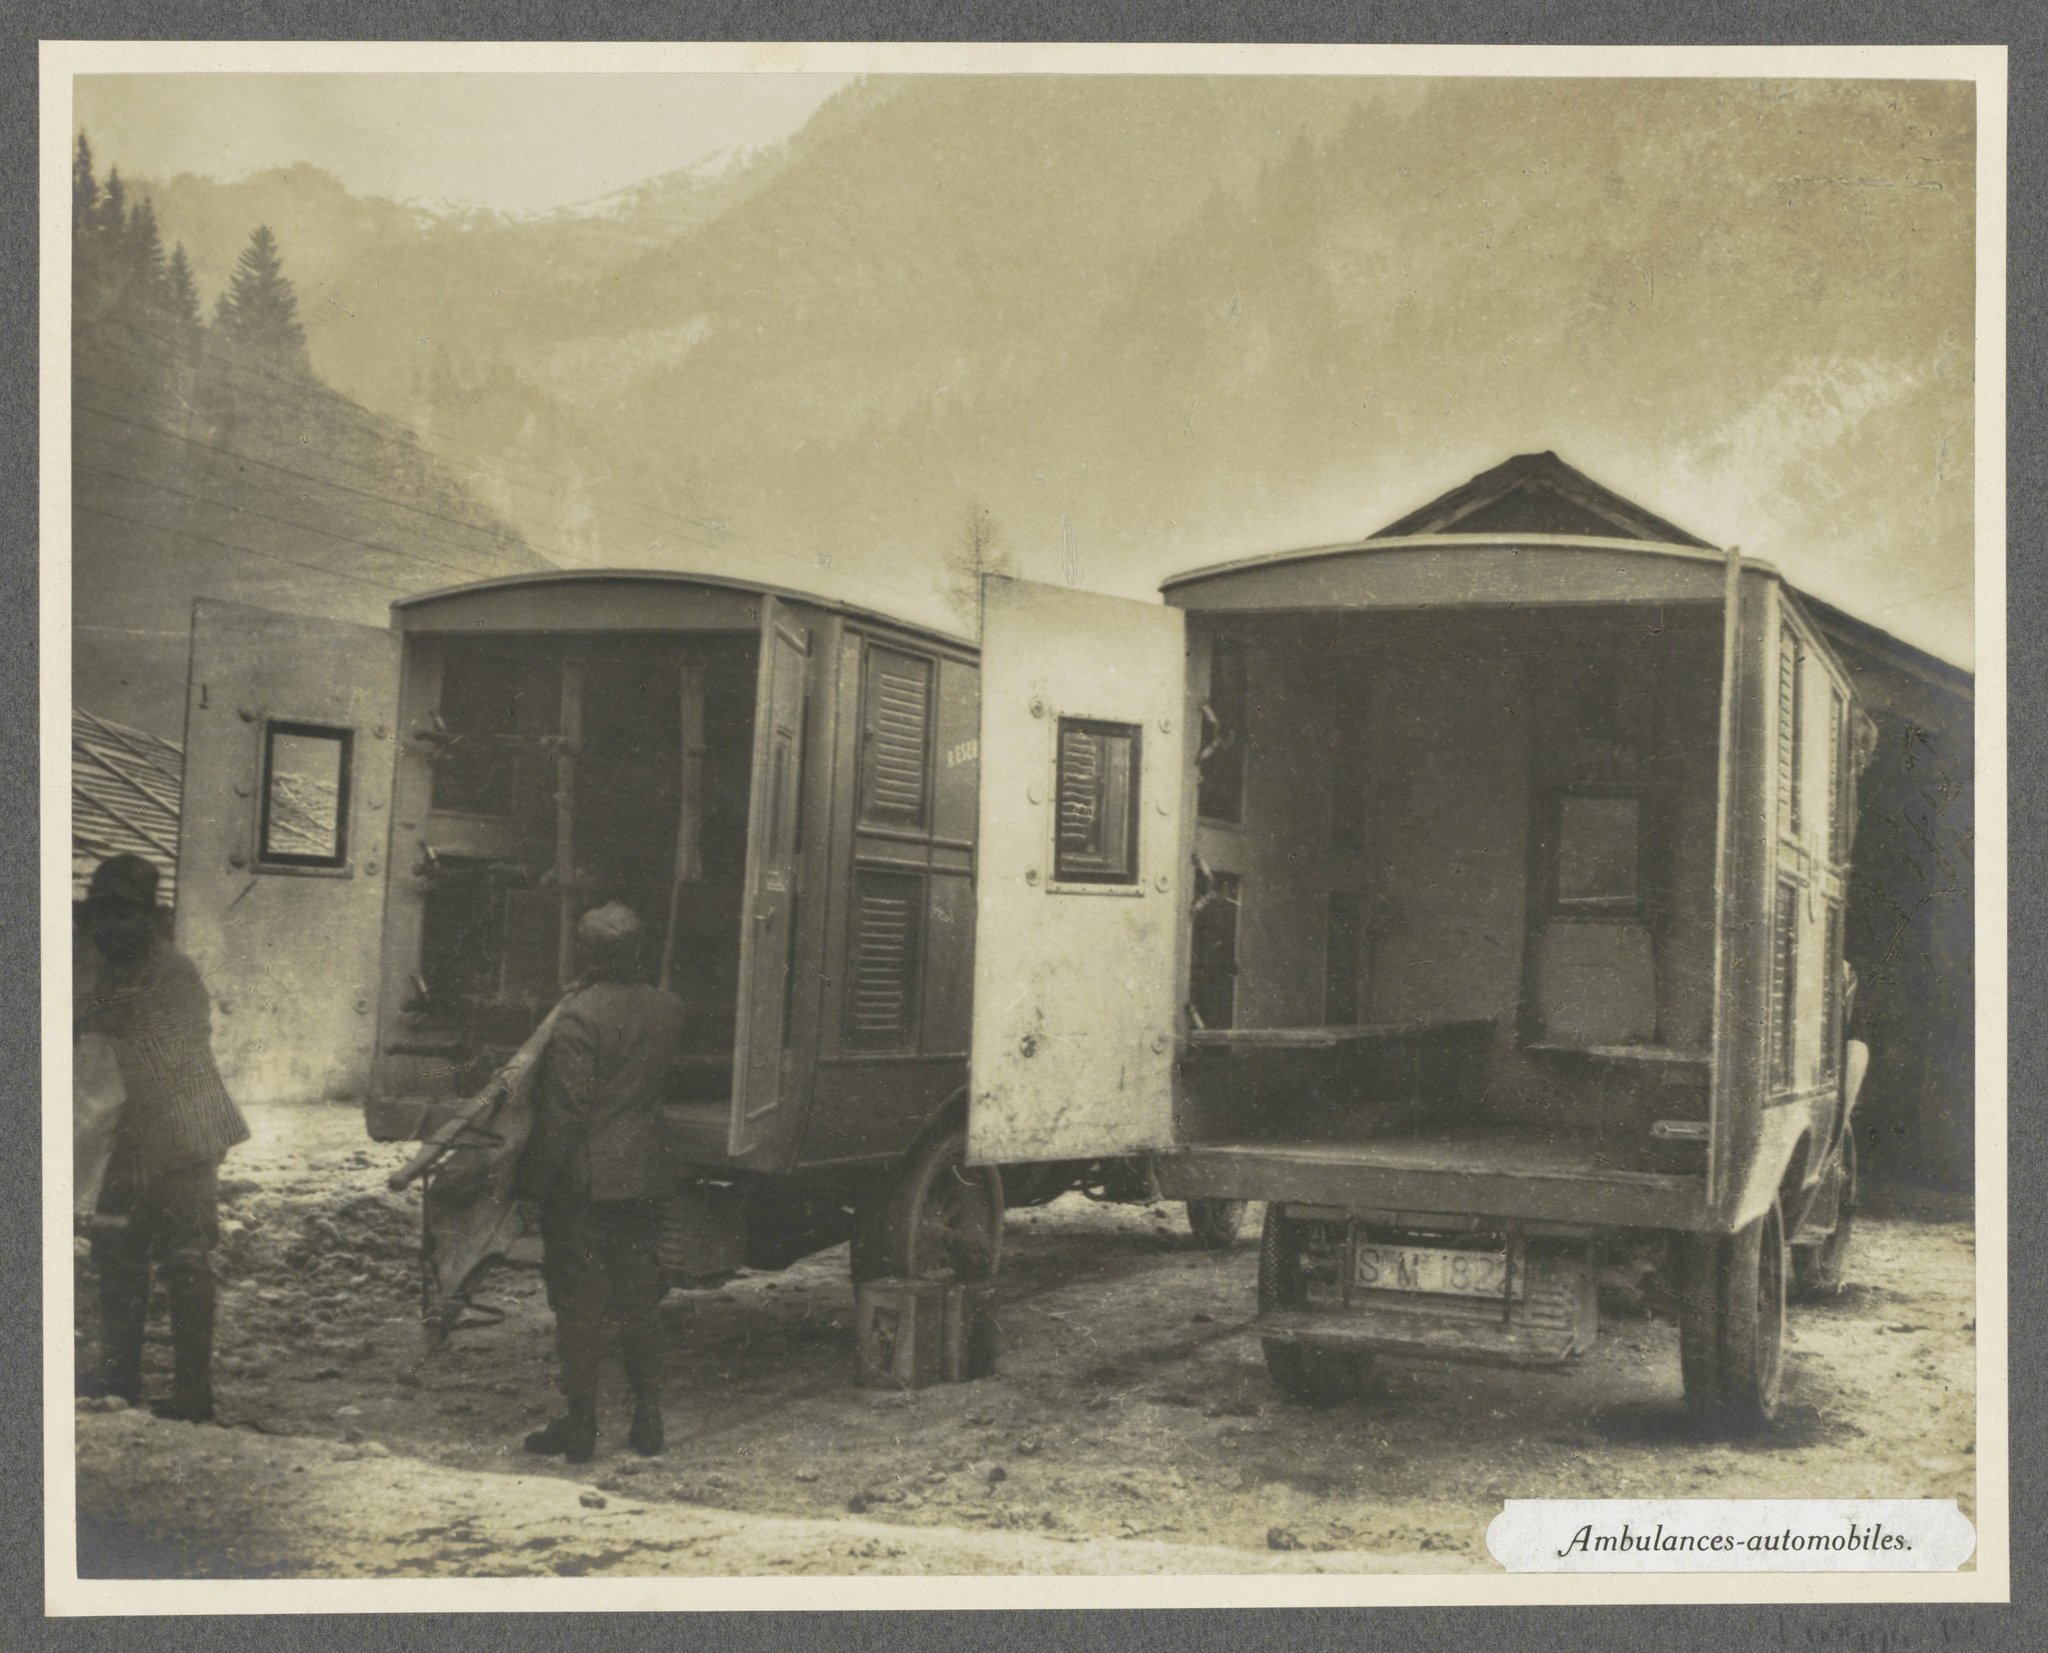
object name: photograph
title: Militairen sjouwen brancards aan de achterzijde van twee ambulances, vermoedelijk Italianen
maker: henri de rothschild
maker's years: 1872-1947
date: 1916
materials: photographic support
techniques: gelatin silver print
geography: dolomites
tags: (carrying a person on a) litter, stretcher, war (+ land forces), ambulance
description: Onderdeel van Fotoalbum Medische missie H. de Rothschild naar het Italiaanse front 1916.